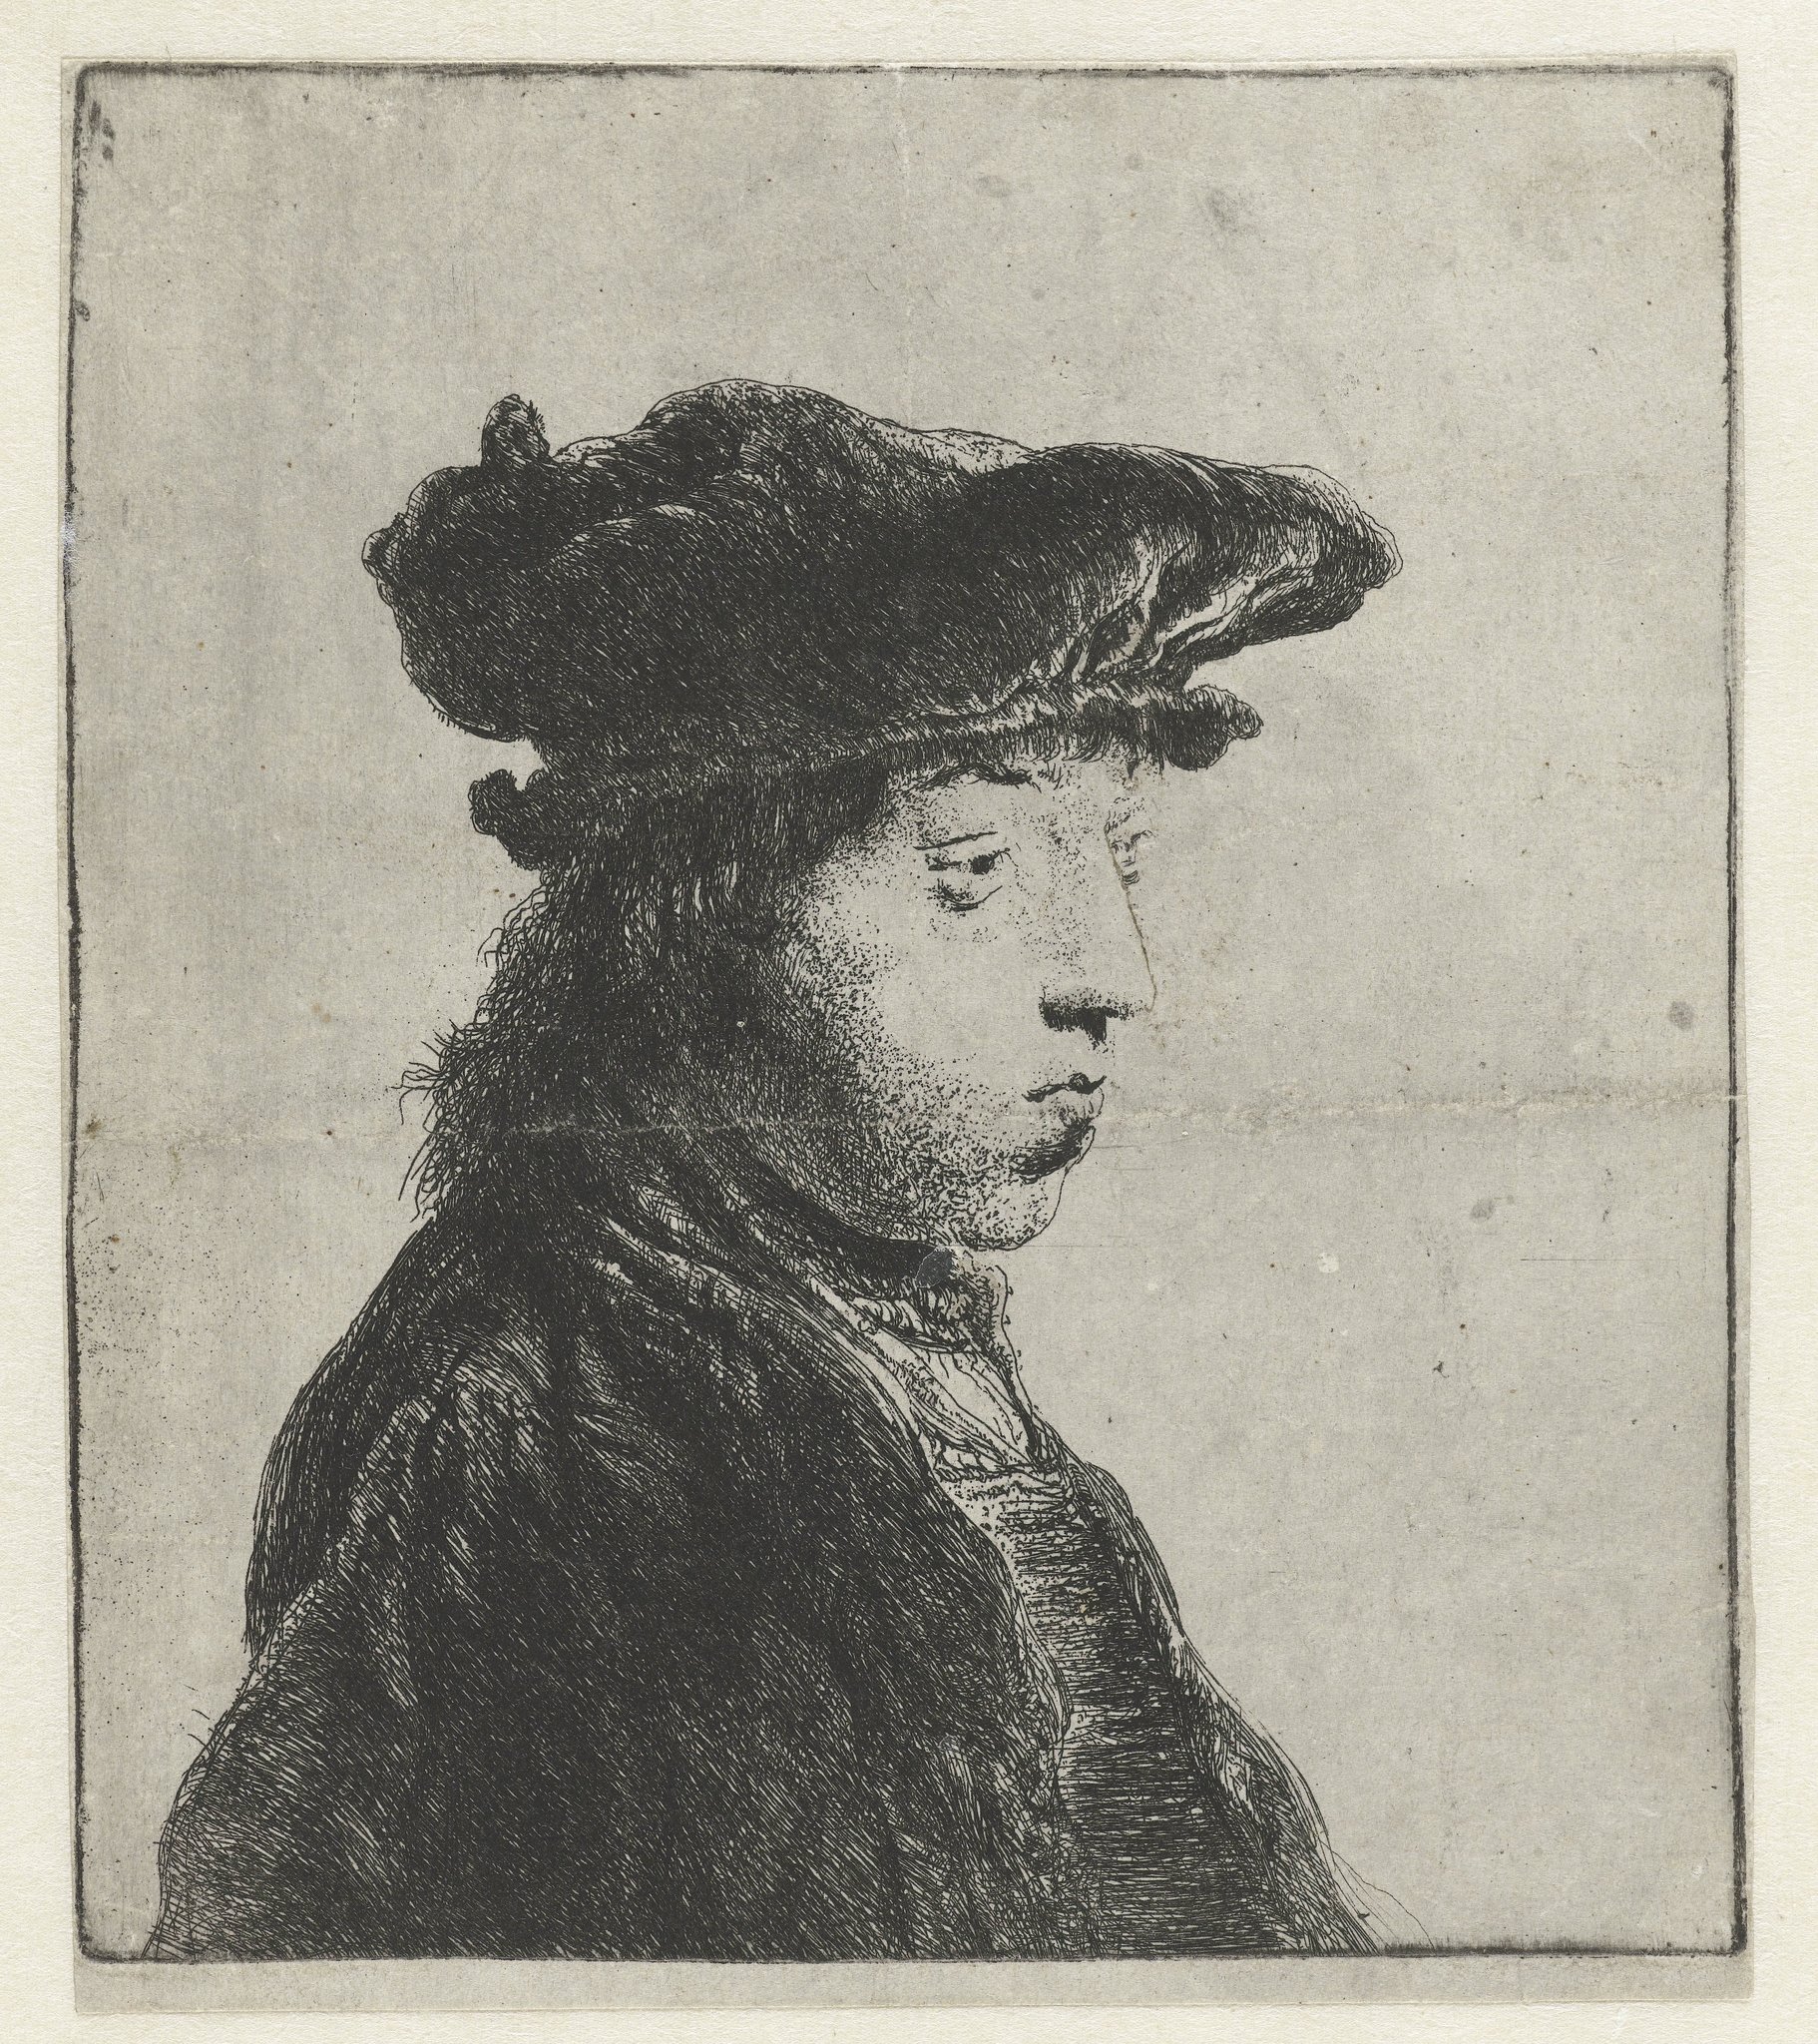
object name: print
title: Borstbeeld van een jonge man met fluwelen baret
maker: jan lievens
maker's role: draughtsman, painter, print maker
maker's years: 1607-1674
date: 1631-1632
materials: paper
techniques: etching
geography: leiden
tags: youth, adolescent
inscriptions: collector's mark: Lugt 240